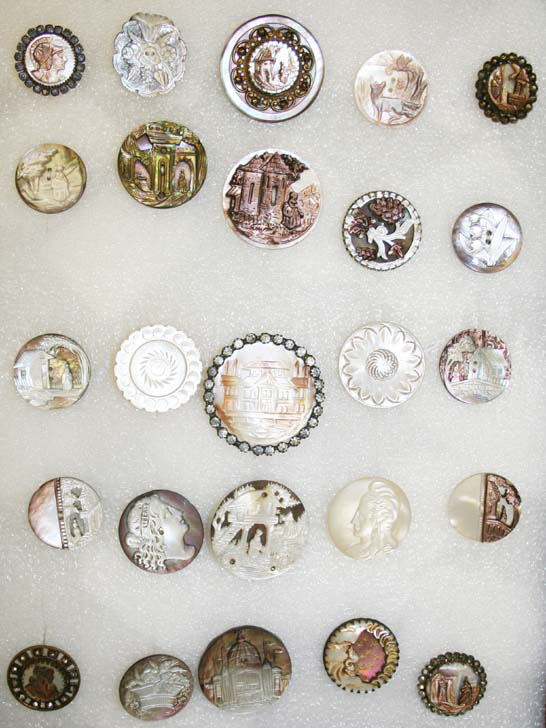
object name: button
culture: american or european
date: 1850-1870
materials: mother of pearl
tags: buildings,profiles